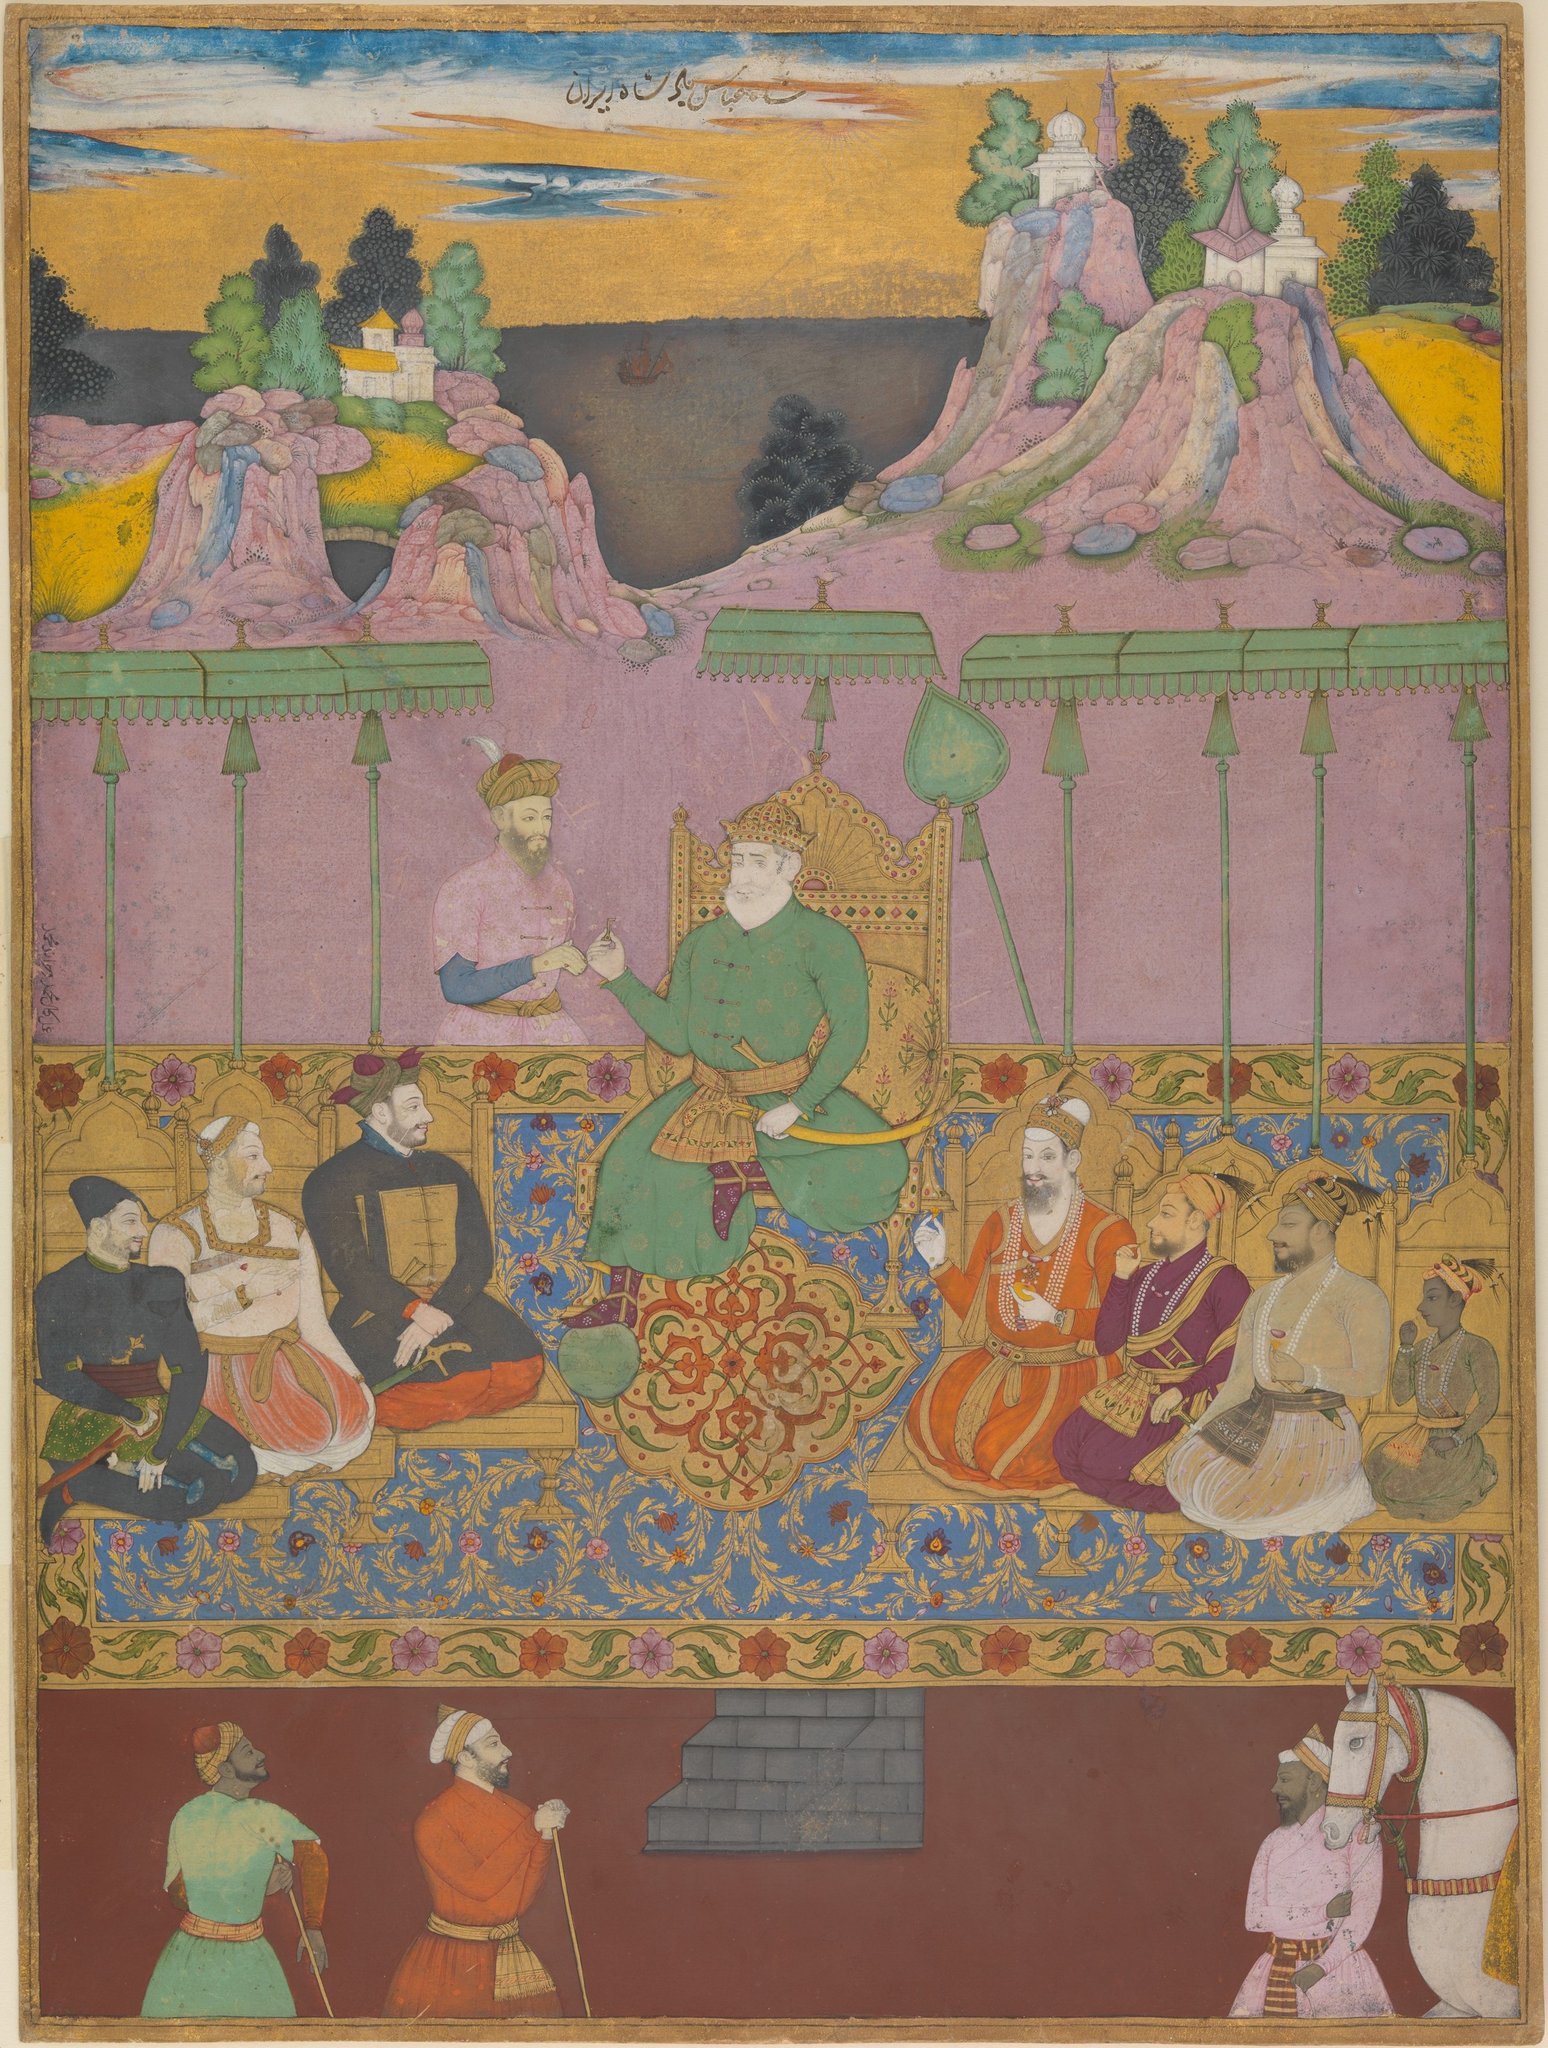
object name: illustrated album leaf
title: The House of Bijapur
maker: kamal muhammad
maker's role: artist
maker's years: 1655-1705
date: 1680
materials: gold, ink, paper, silver, watercolor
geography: india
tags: men,horses,landscapes